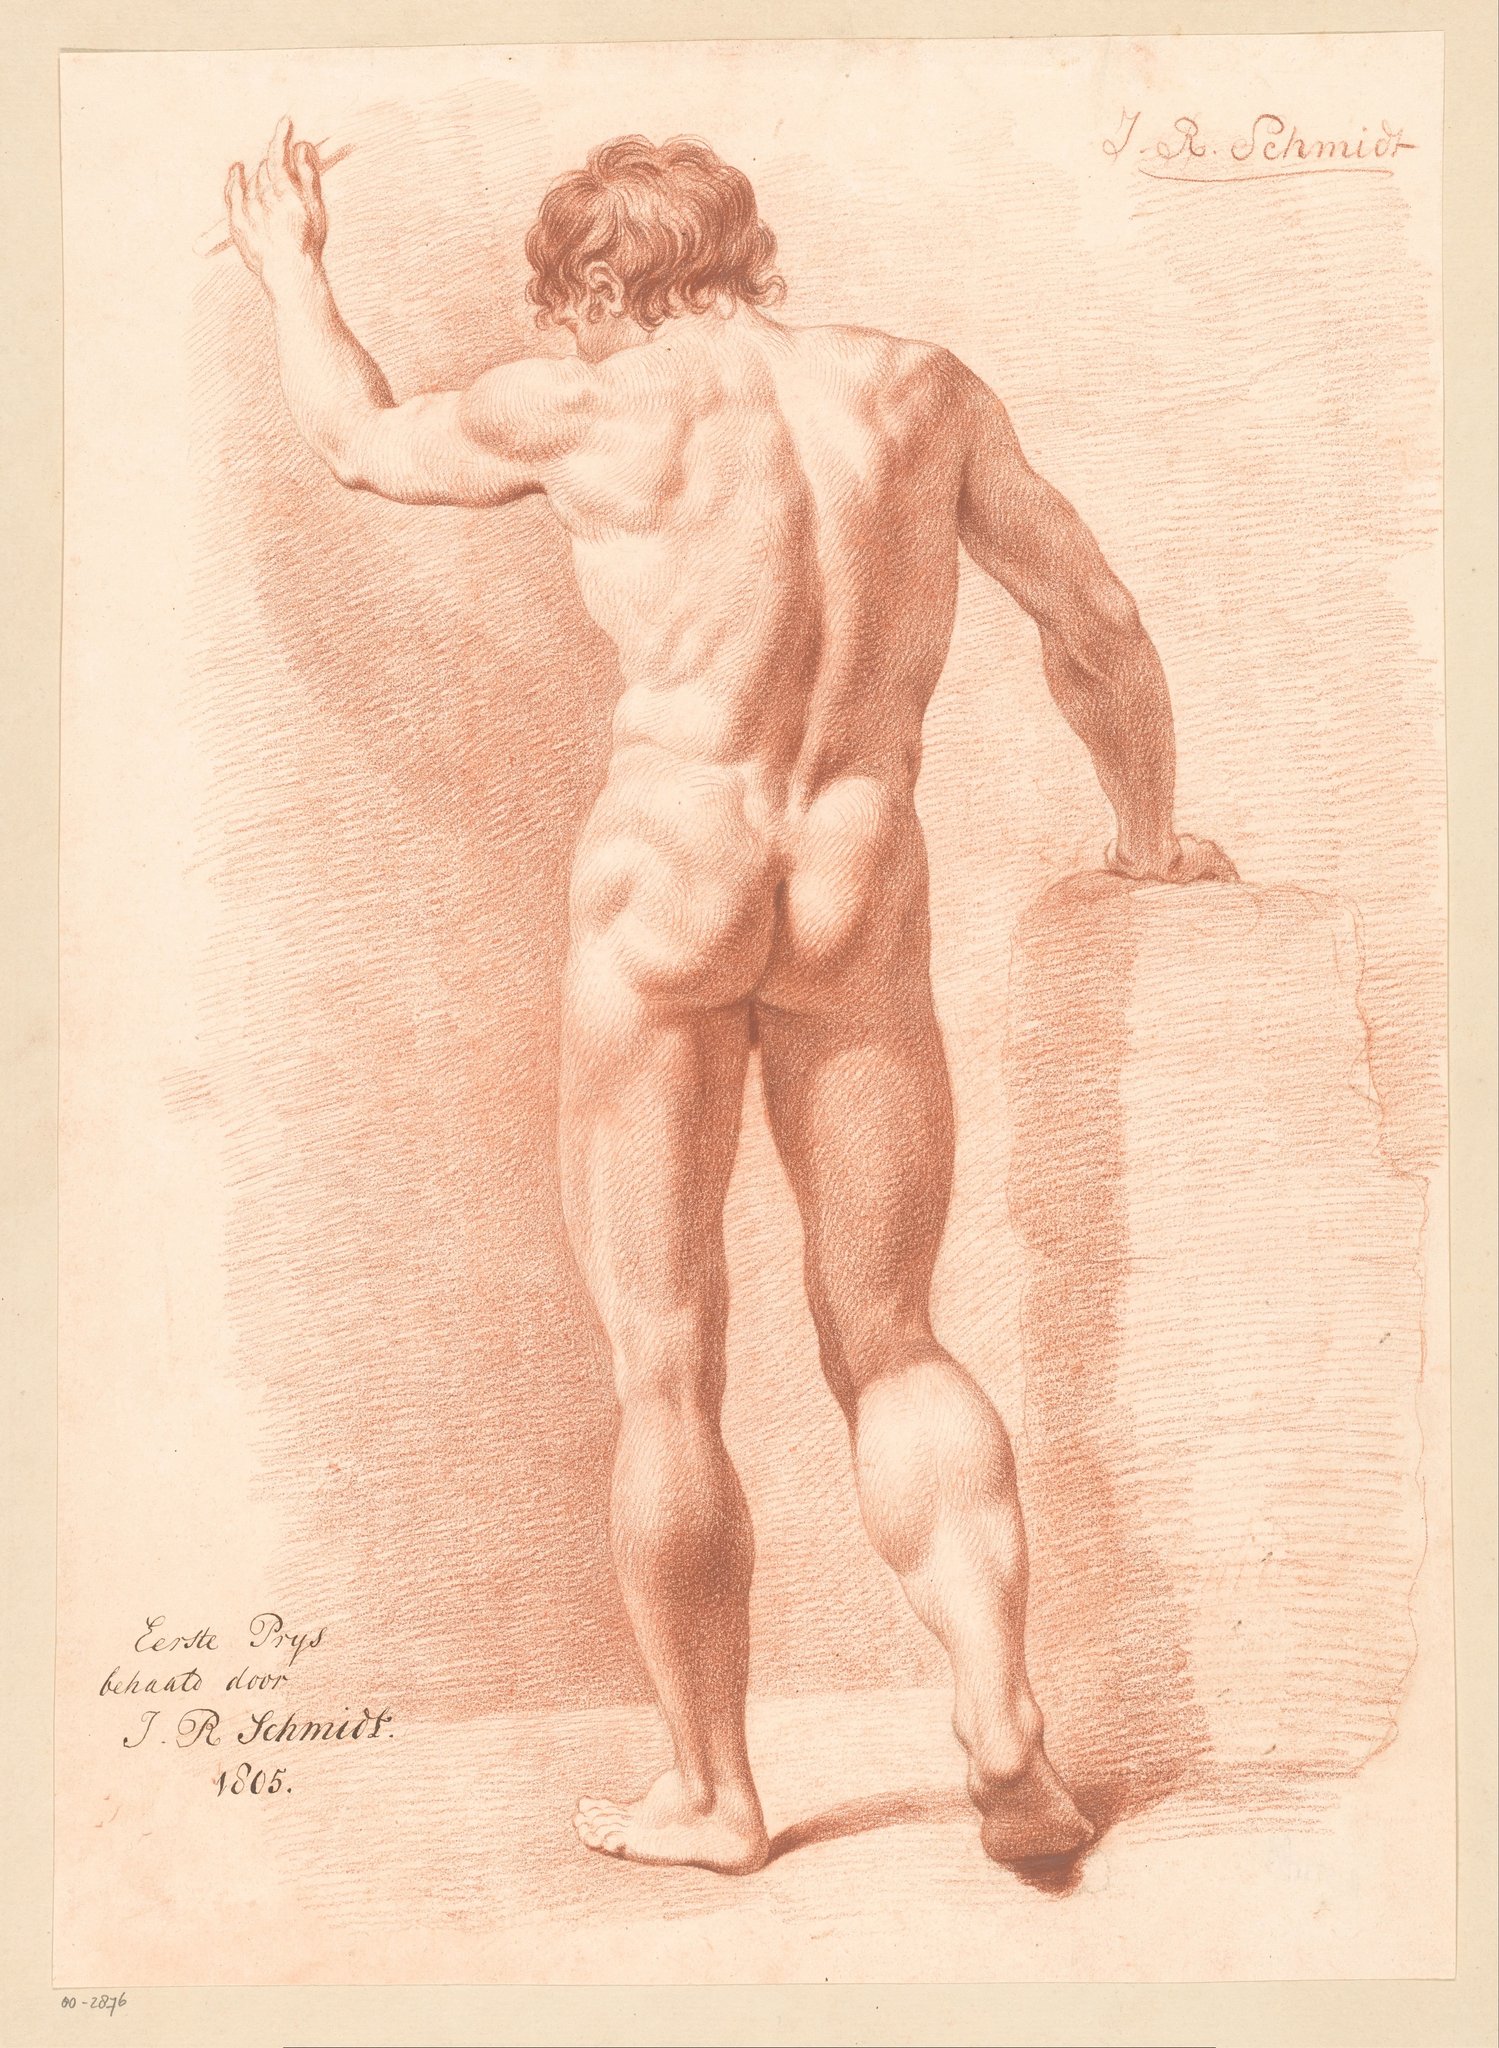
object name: drawing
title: Staand mannelijk naakt, op de rug gezien (1e prijs 1805)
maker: izaak riewert schmidt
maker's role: draughtsman, print maker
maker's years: 1781-1826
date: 1805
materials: chalk, charcoal, paper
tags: standing figure (+ nude human being)